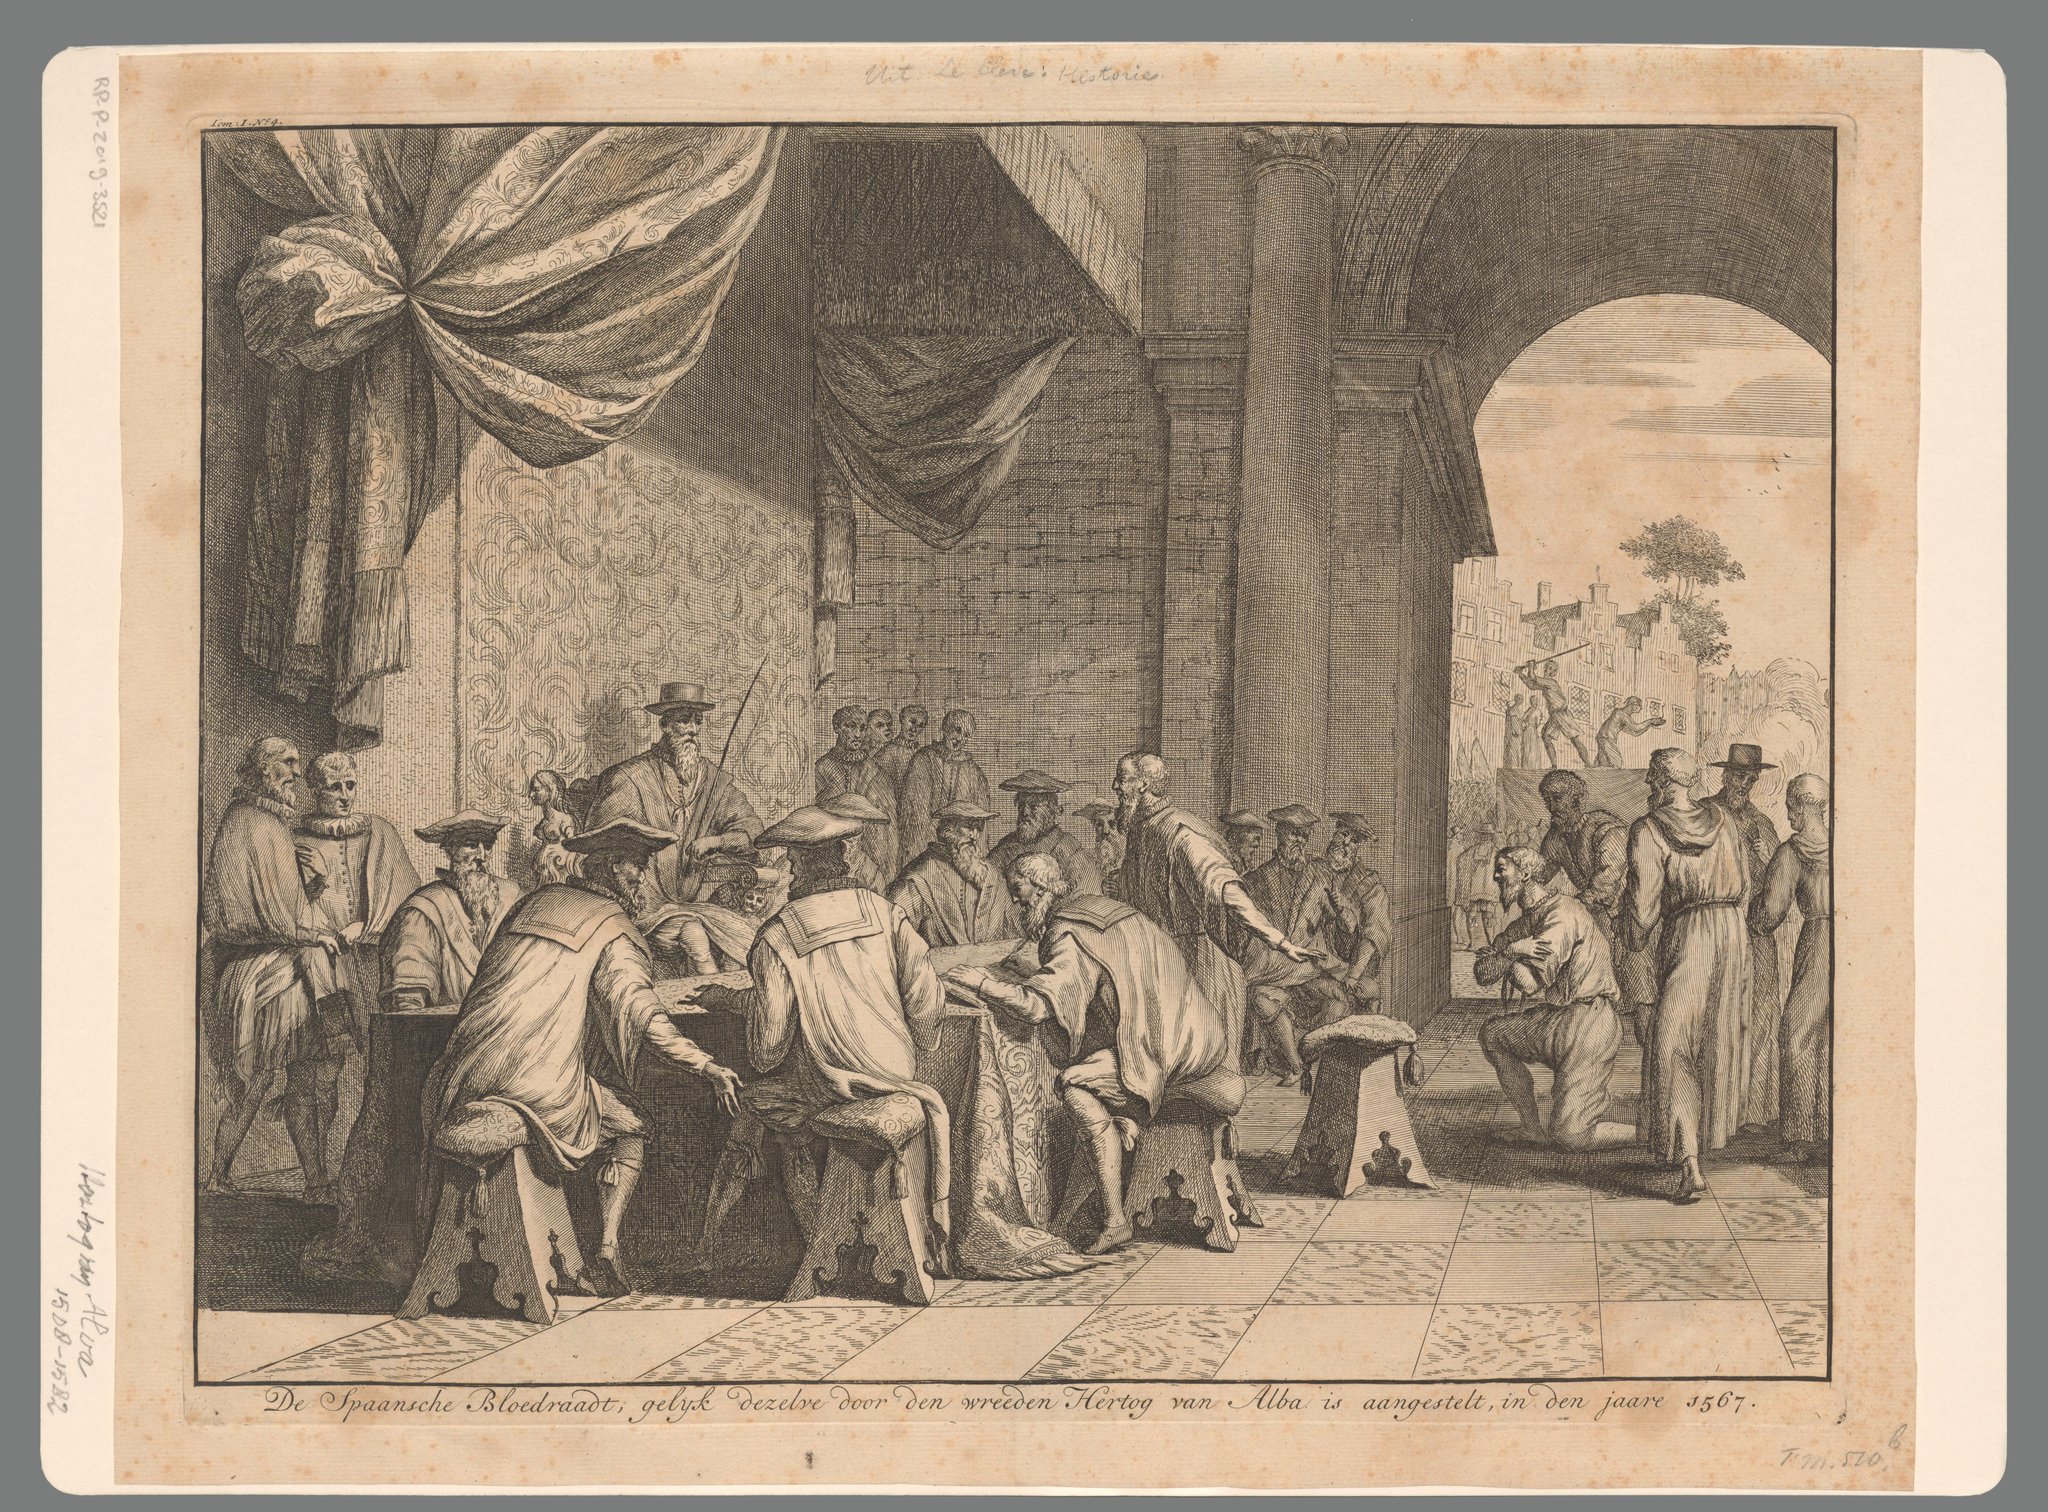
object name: print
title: Alva zit de Spaanse Bloedraad voor, 1567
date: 1730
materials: paper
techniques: etching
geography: amsterdam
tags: fernando álvarez de toledo (3rd duke of alba), court session (court of justice), violent death by beheading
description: Prent uit: Clerc, Jean le. Geschiedenissen der Vereenigde Nederlanden, sedert den aanvang van die Republyk tot op den vrede van Utrecht (...). Amsterdam: Zacharias Chatelain, 1730, dl. 1. Prent voor het eerst verschenen in: Bor, Pieter Christiansz. Oorspronk, begin, en vervolgh der Nederlandsche Oorlogen. Amsterdam: weduwe van Joannes van Someren, Abraham Wolfgang, Dirk en Hendrick Boom, 1679-1684. In de daaropvolgende jaren in verschillende historische werken verschenen.